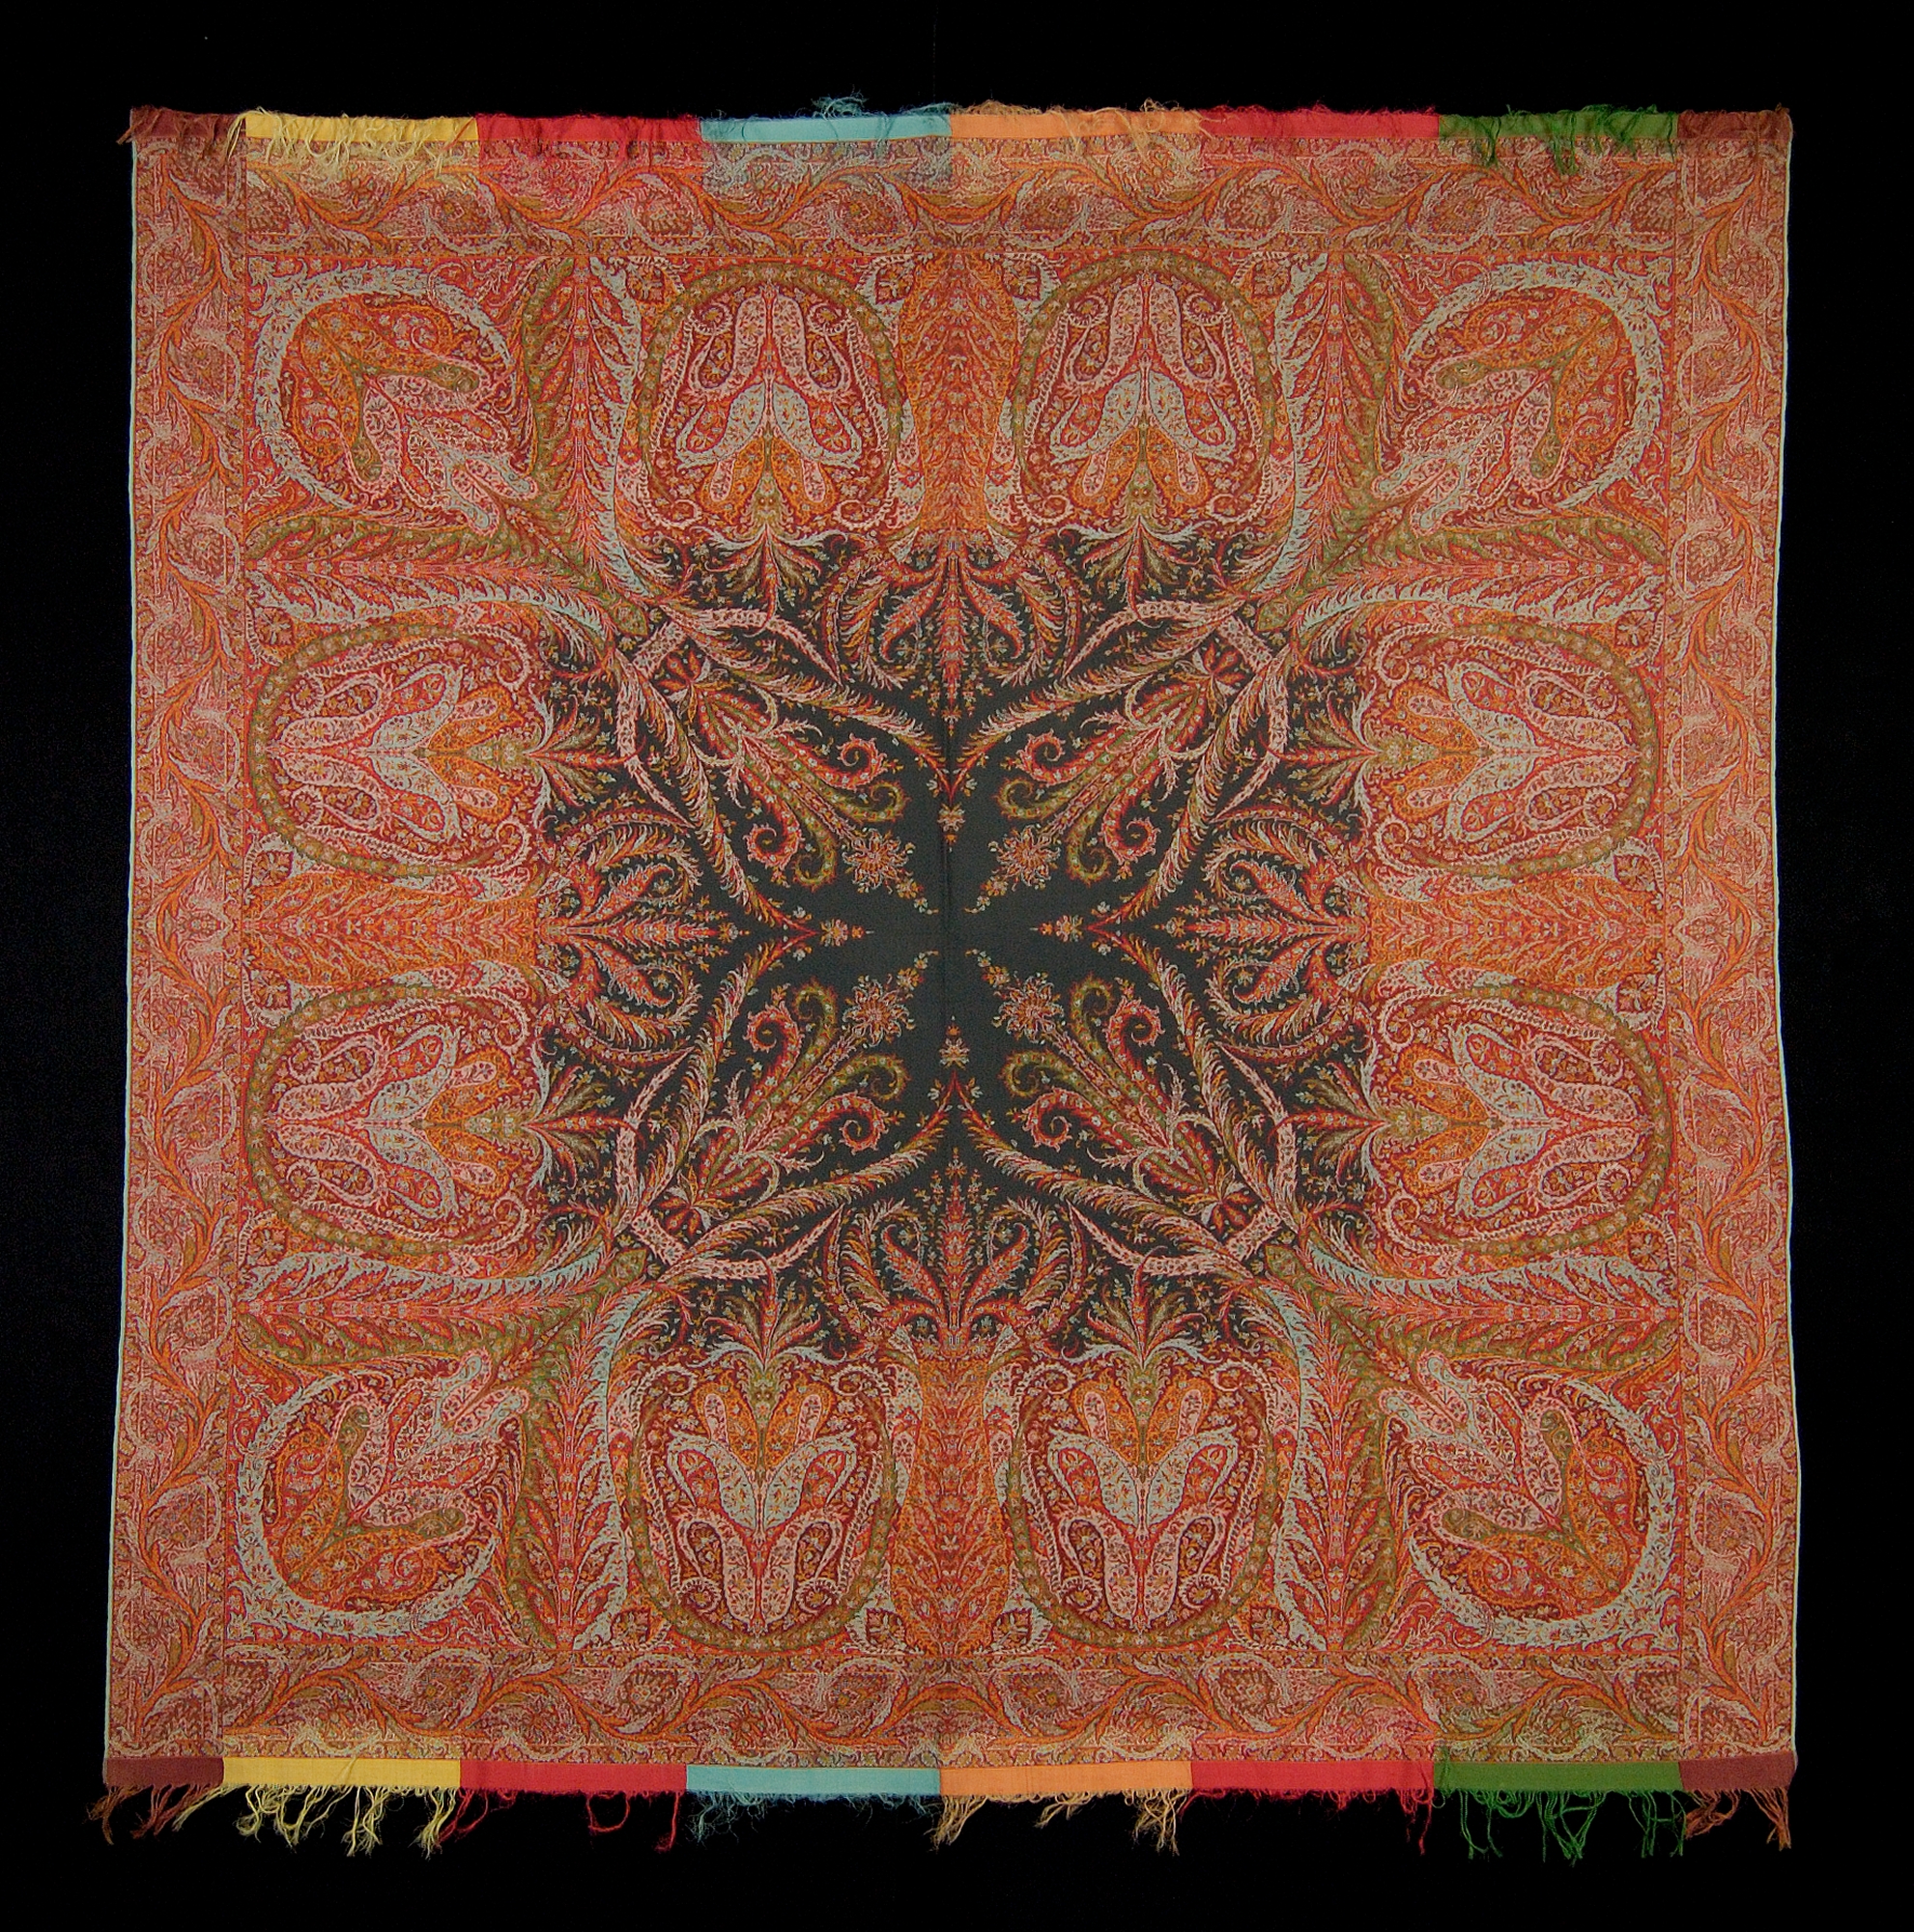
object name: shawl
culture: scottish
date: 1846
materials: wool